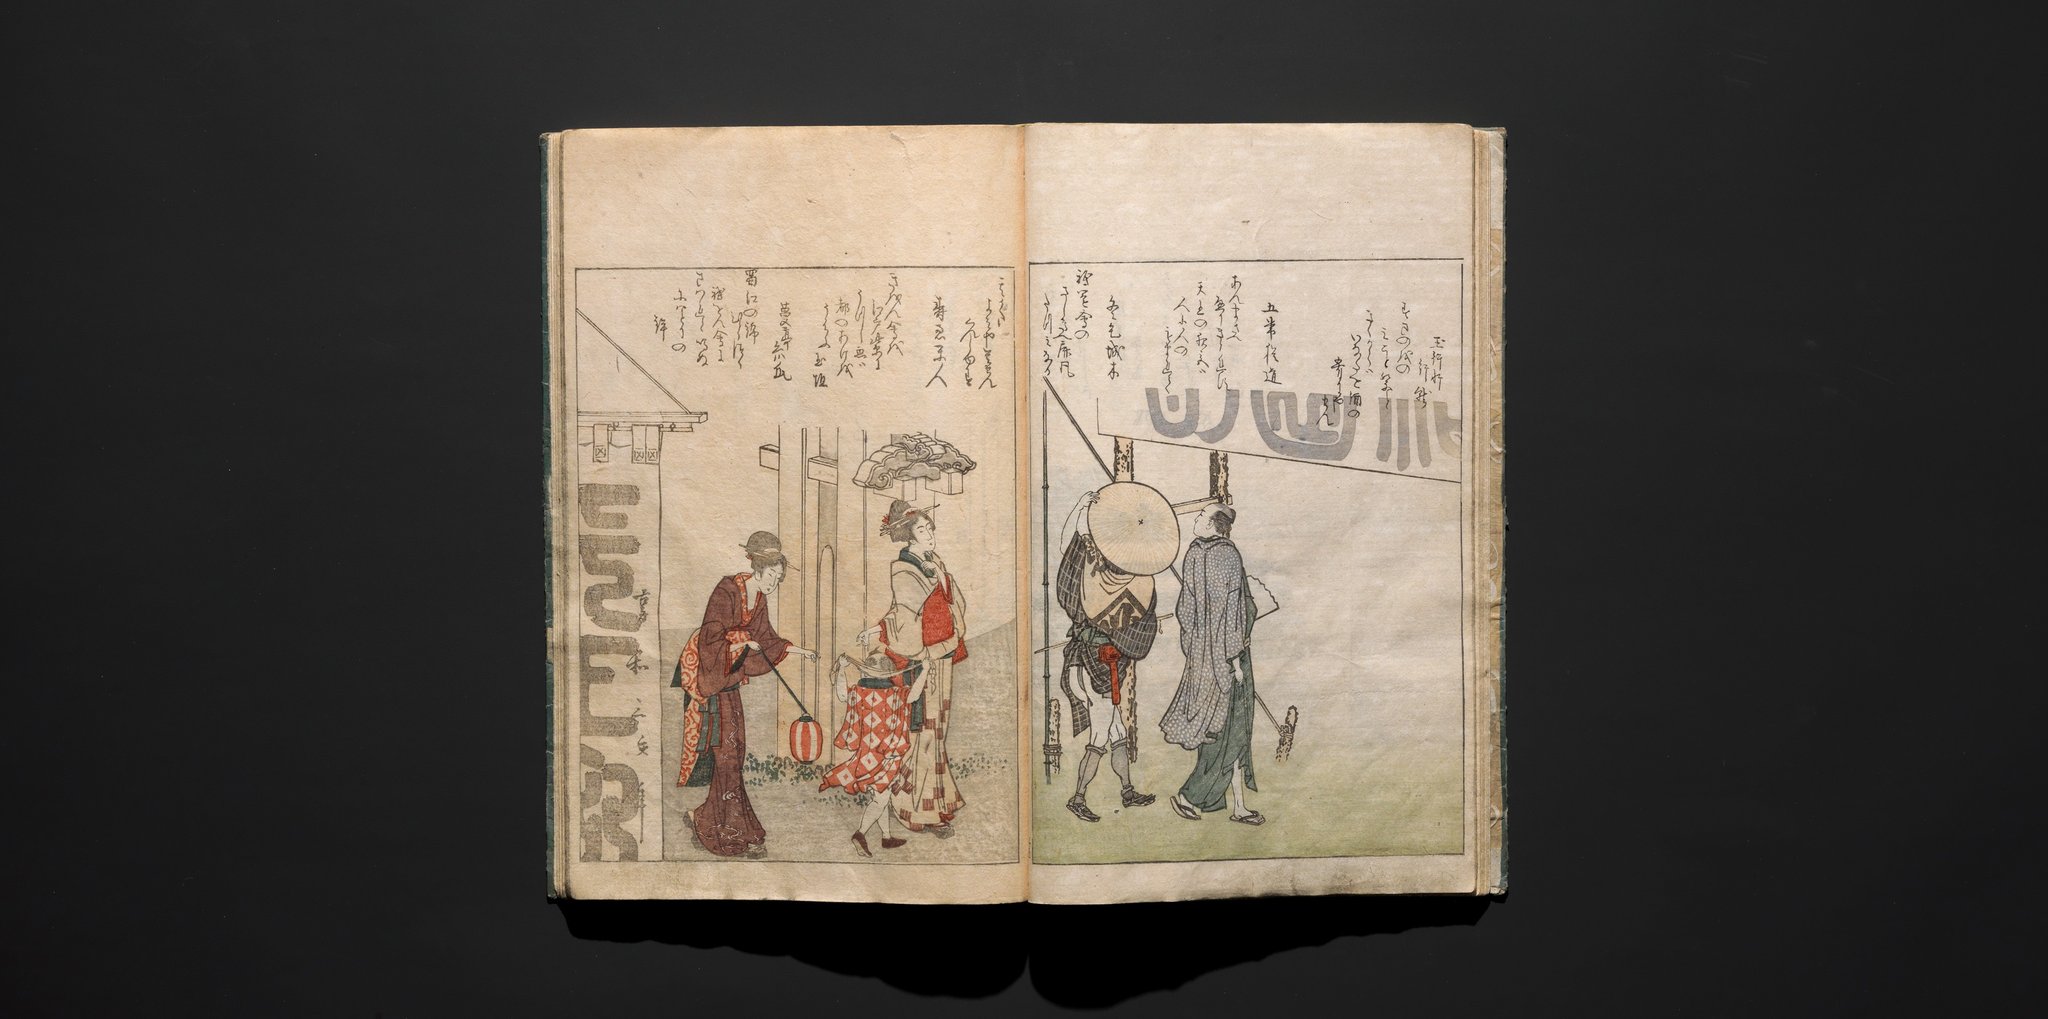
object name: illustrated book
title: Picture Book of Kyōka Poems: Mountains upon Mountains (Ehon kyōka yama mata yama) 画本狂歌山満多山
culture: japanese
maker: katsushika hokusai 葛飾北斎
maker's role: artist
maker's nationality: japanese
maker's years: 1760-1849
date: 1804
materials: ink, paper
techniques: woodblock print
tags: poetry,men,women